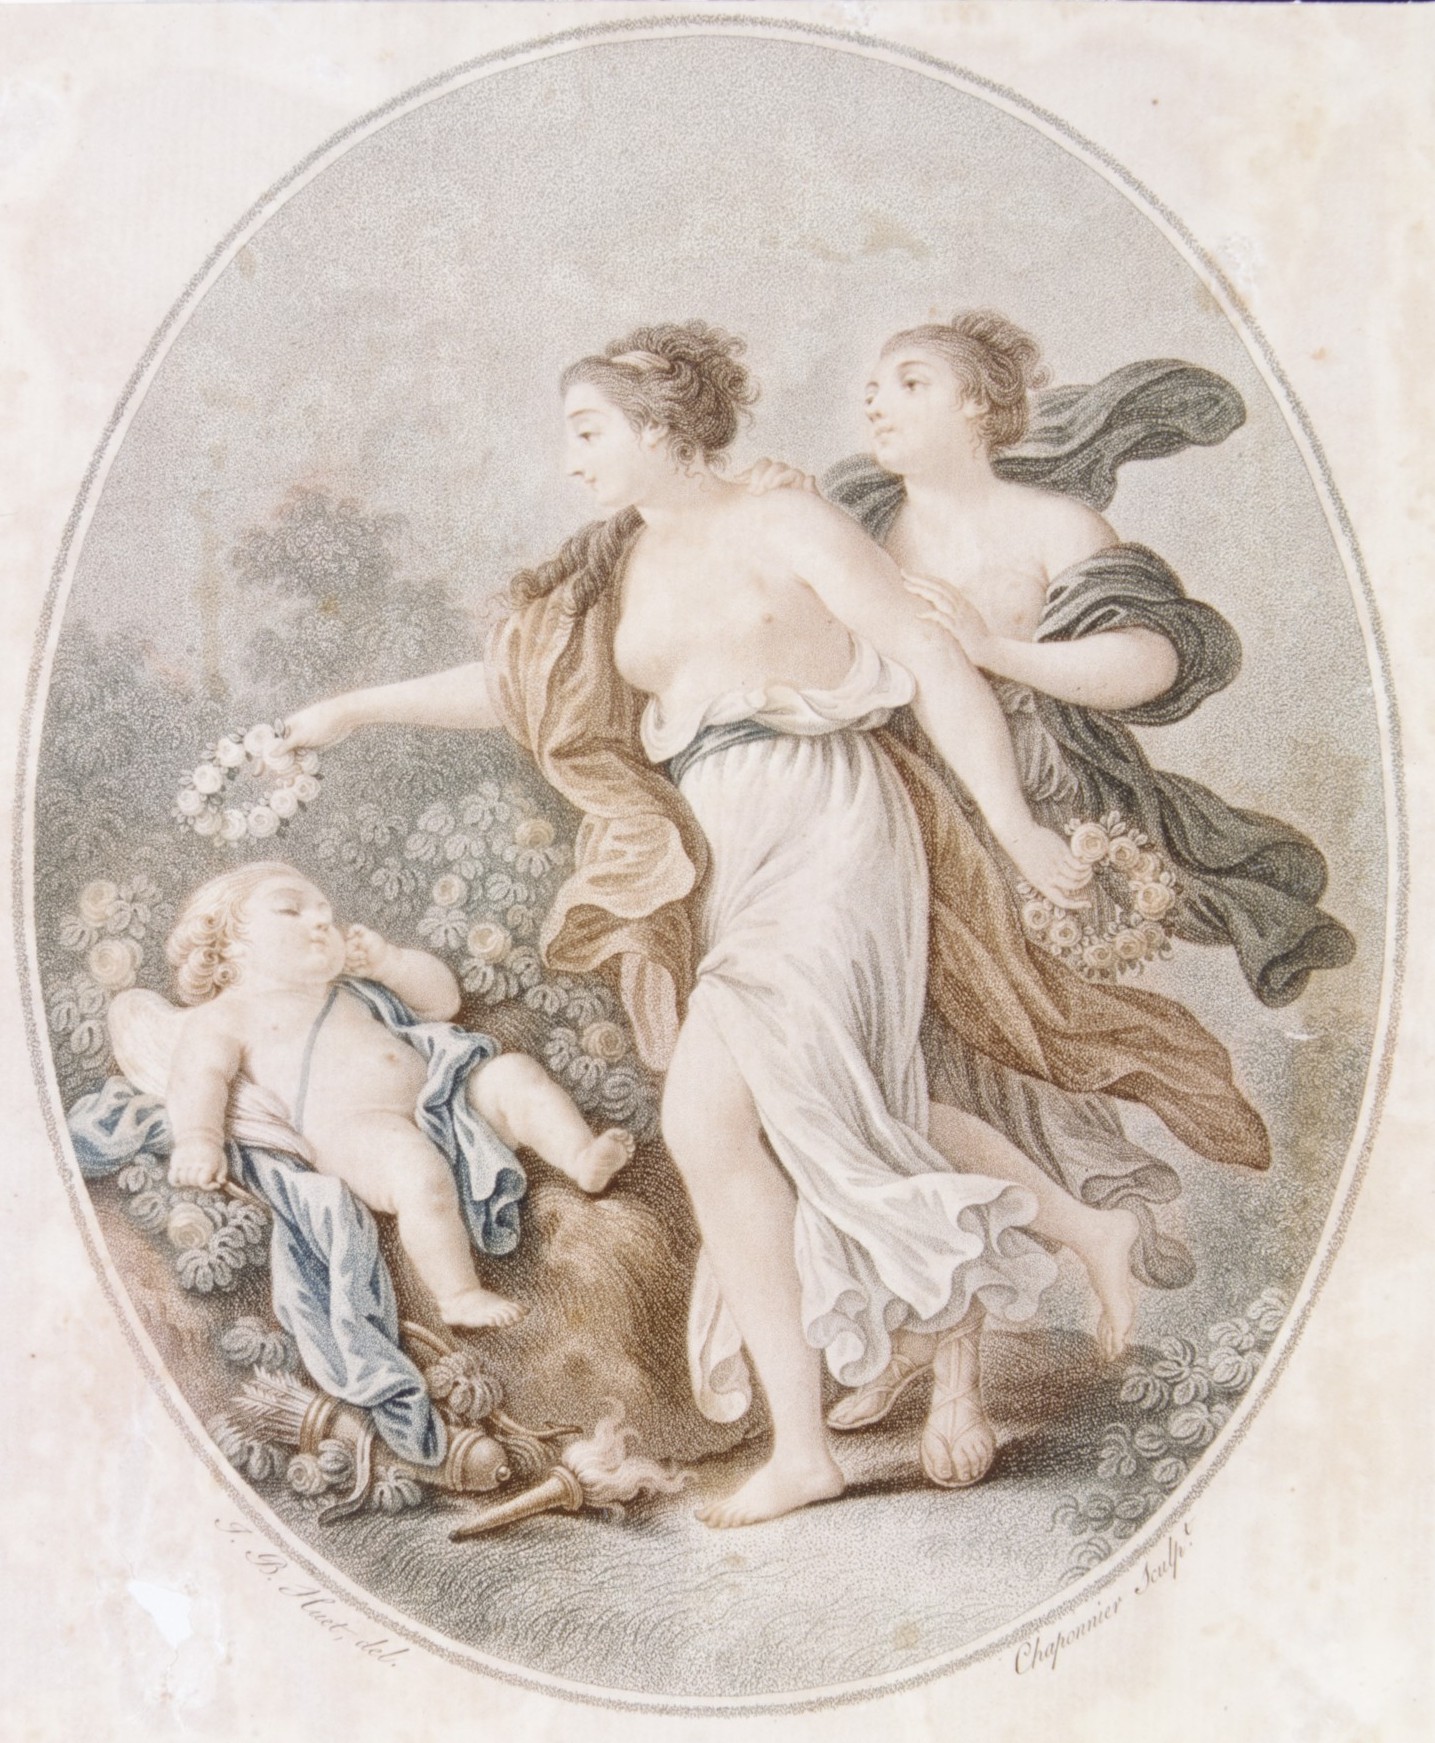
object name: print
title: L'Amour couronné par les Graces (Cupid crowned by the Graces)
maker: alexandre chaponnier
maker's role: artist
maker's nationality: french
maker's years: 1753-1805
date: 1770-1805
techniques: printing, engraving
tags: cupid,goddess